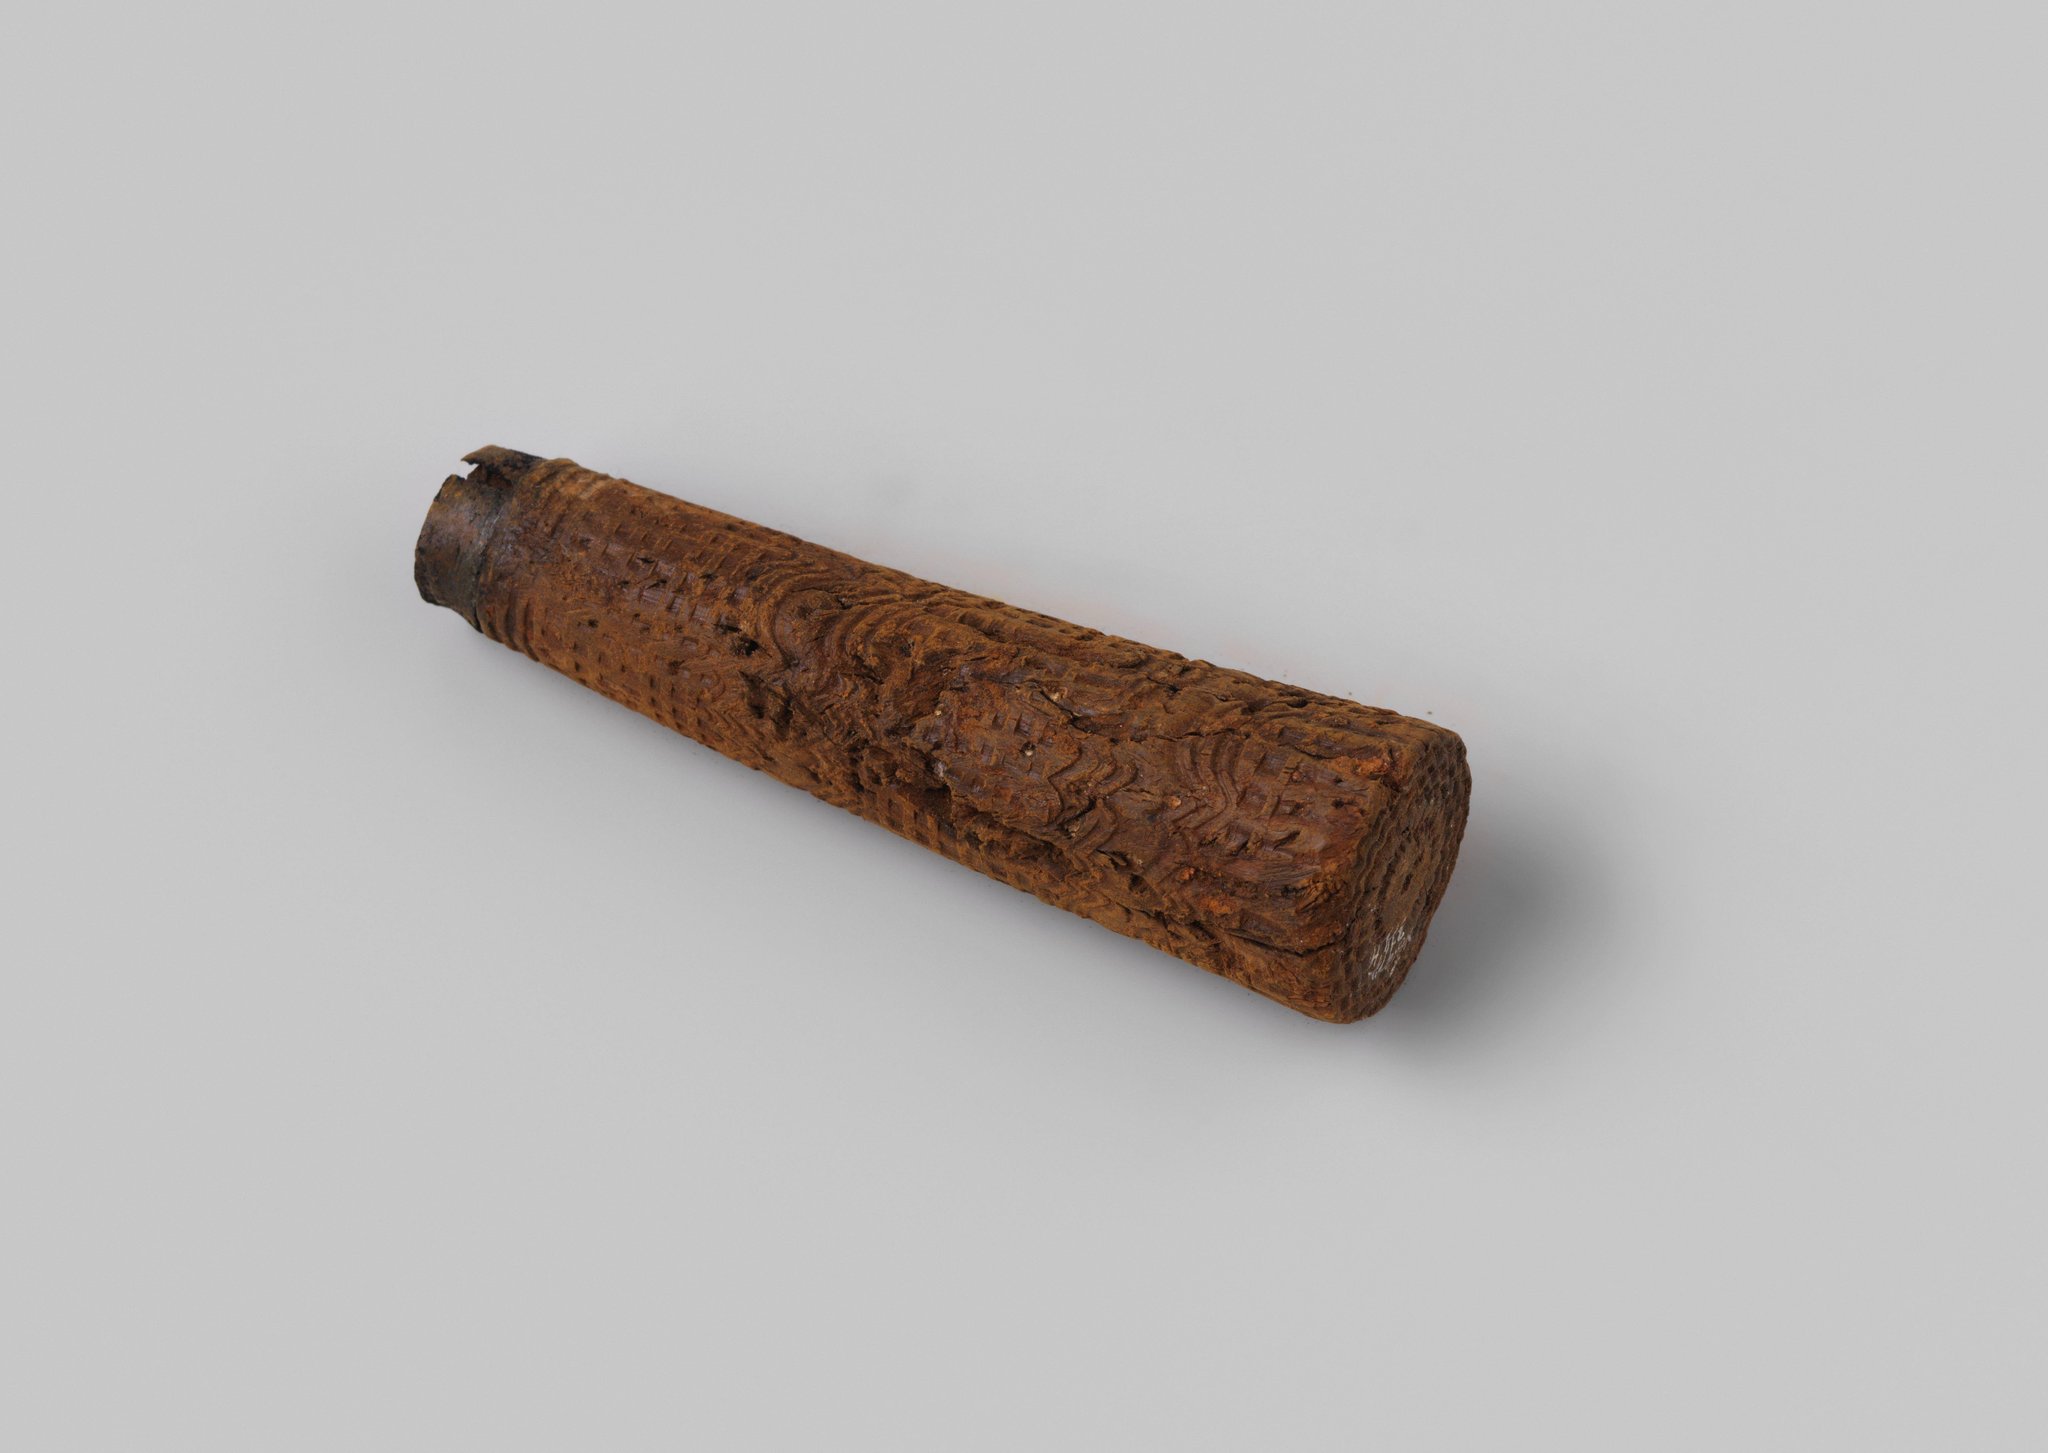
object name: knife handle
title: Messenheft uit het wrak van de Oost-Indiëvaarder Hollandia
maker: Anonymous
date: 1700-1743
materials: copper, wood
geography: netherlands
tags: verenigde oostindische compagnie, hollandia (schip), annet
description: Knife, handle, cylindrical: tapering; id. NG 1979-403H, ferrules id. NG 1980-27H426.